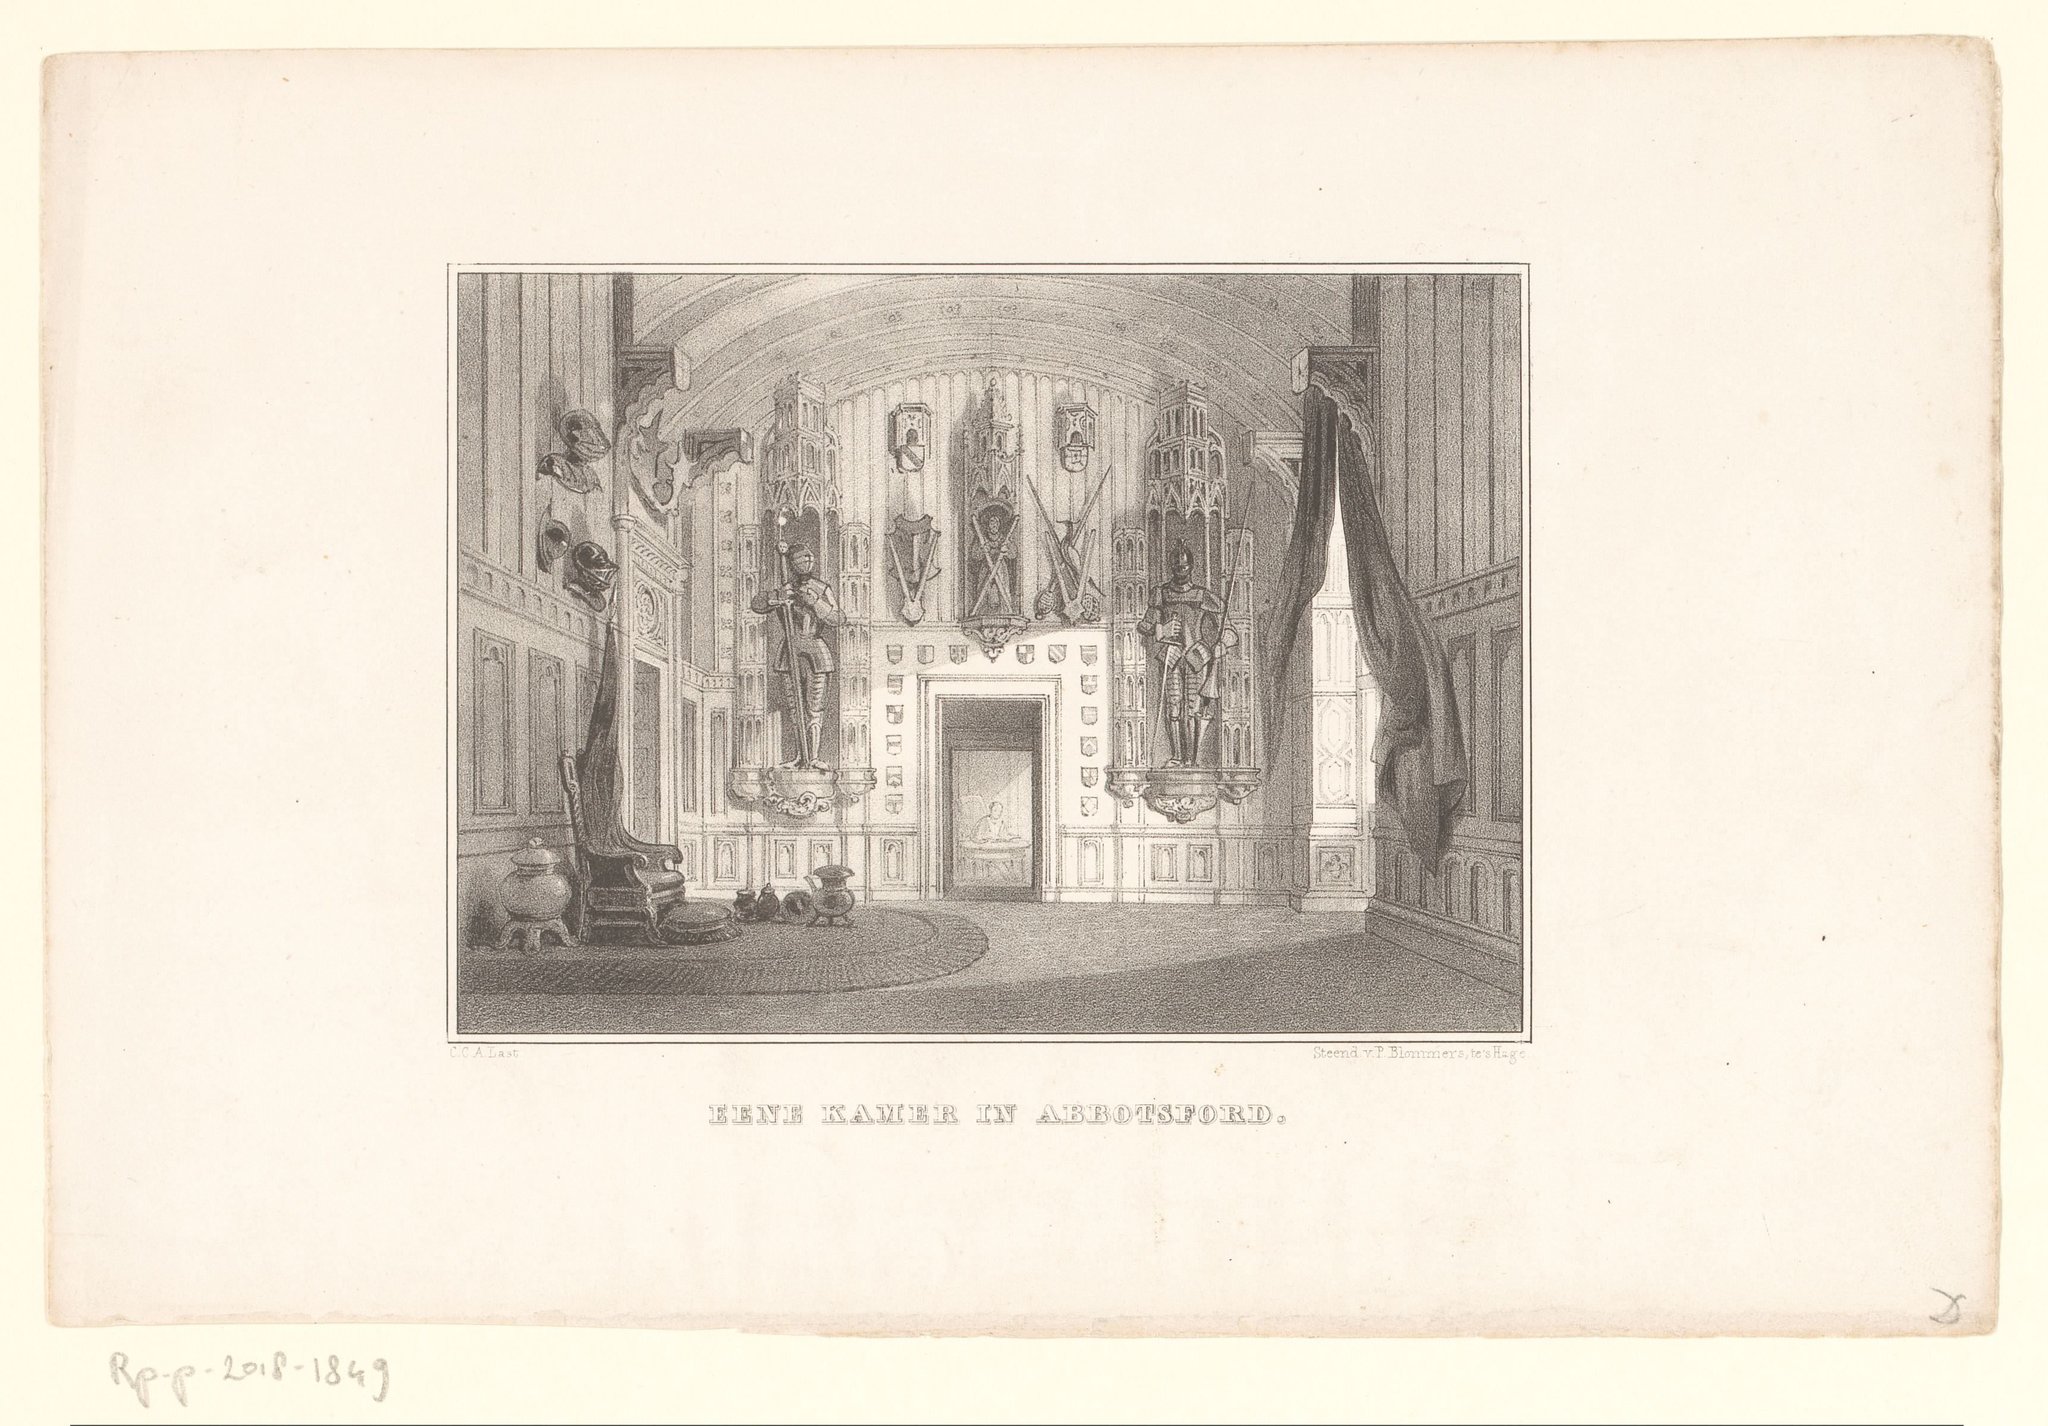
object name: print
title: Eene kamer in Abbotsford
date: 1842-1887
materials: paper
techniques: lithograph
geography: the hague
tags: rural housing, e.g. country-house, villa, cottage - aa - civic architecture: inside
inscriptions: collector's mark: Lugt 2228